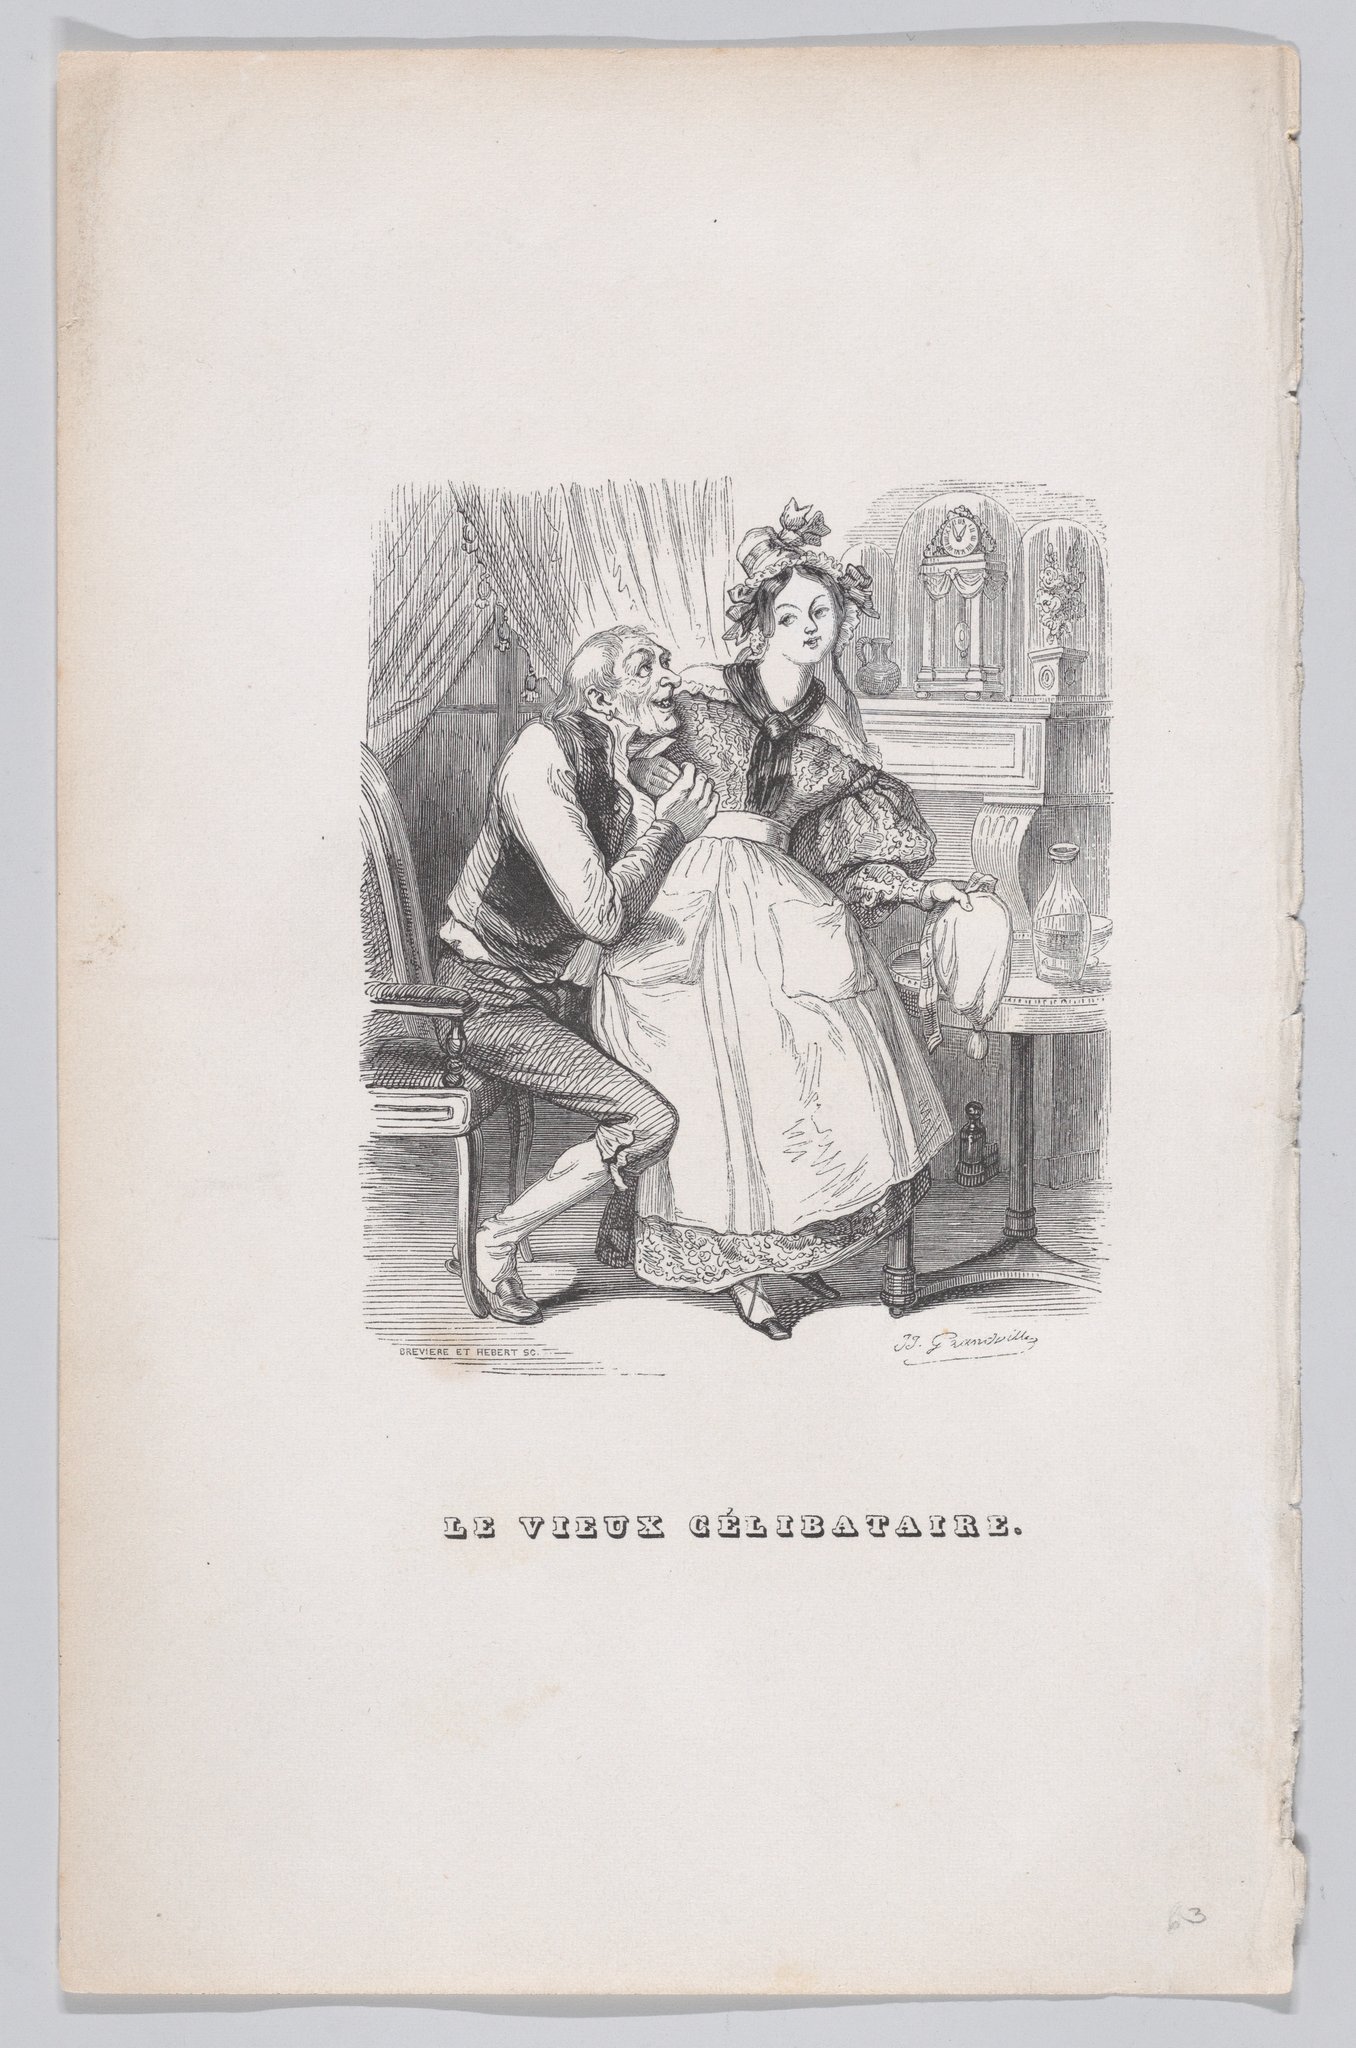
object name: print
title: The Old Bachelor, from "The Complete Works of Béranger"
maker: j. j. grandville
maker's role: illustrator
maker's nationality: french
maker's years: 1803-1847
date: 1836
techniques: engraving